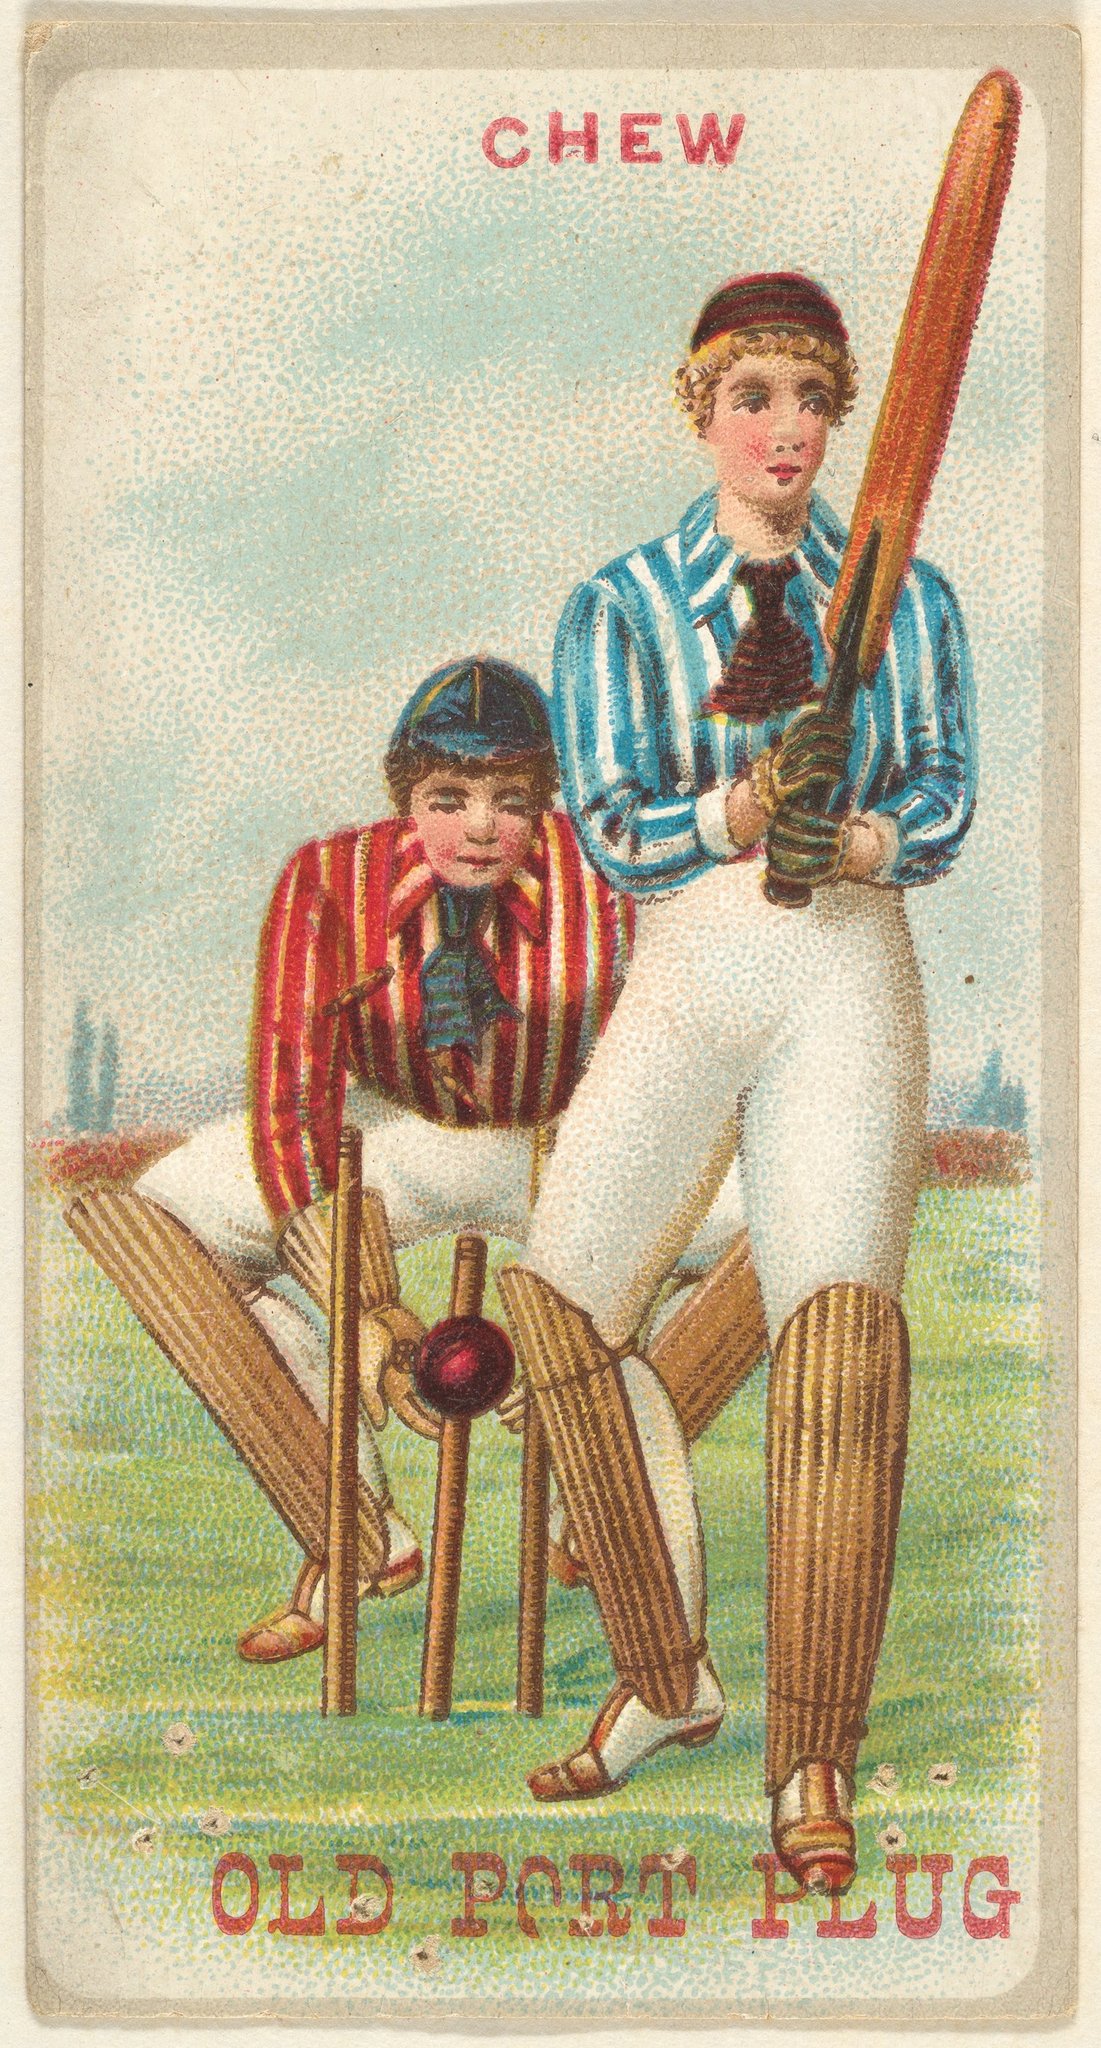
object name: print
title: From the Sports Girls series (N463) for Old Port Plug Tobacco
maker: old port plug tobacco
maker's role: publisher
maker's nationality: american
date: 1889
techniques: color lithograph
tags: women,sports,athletes